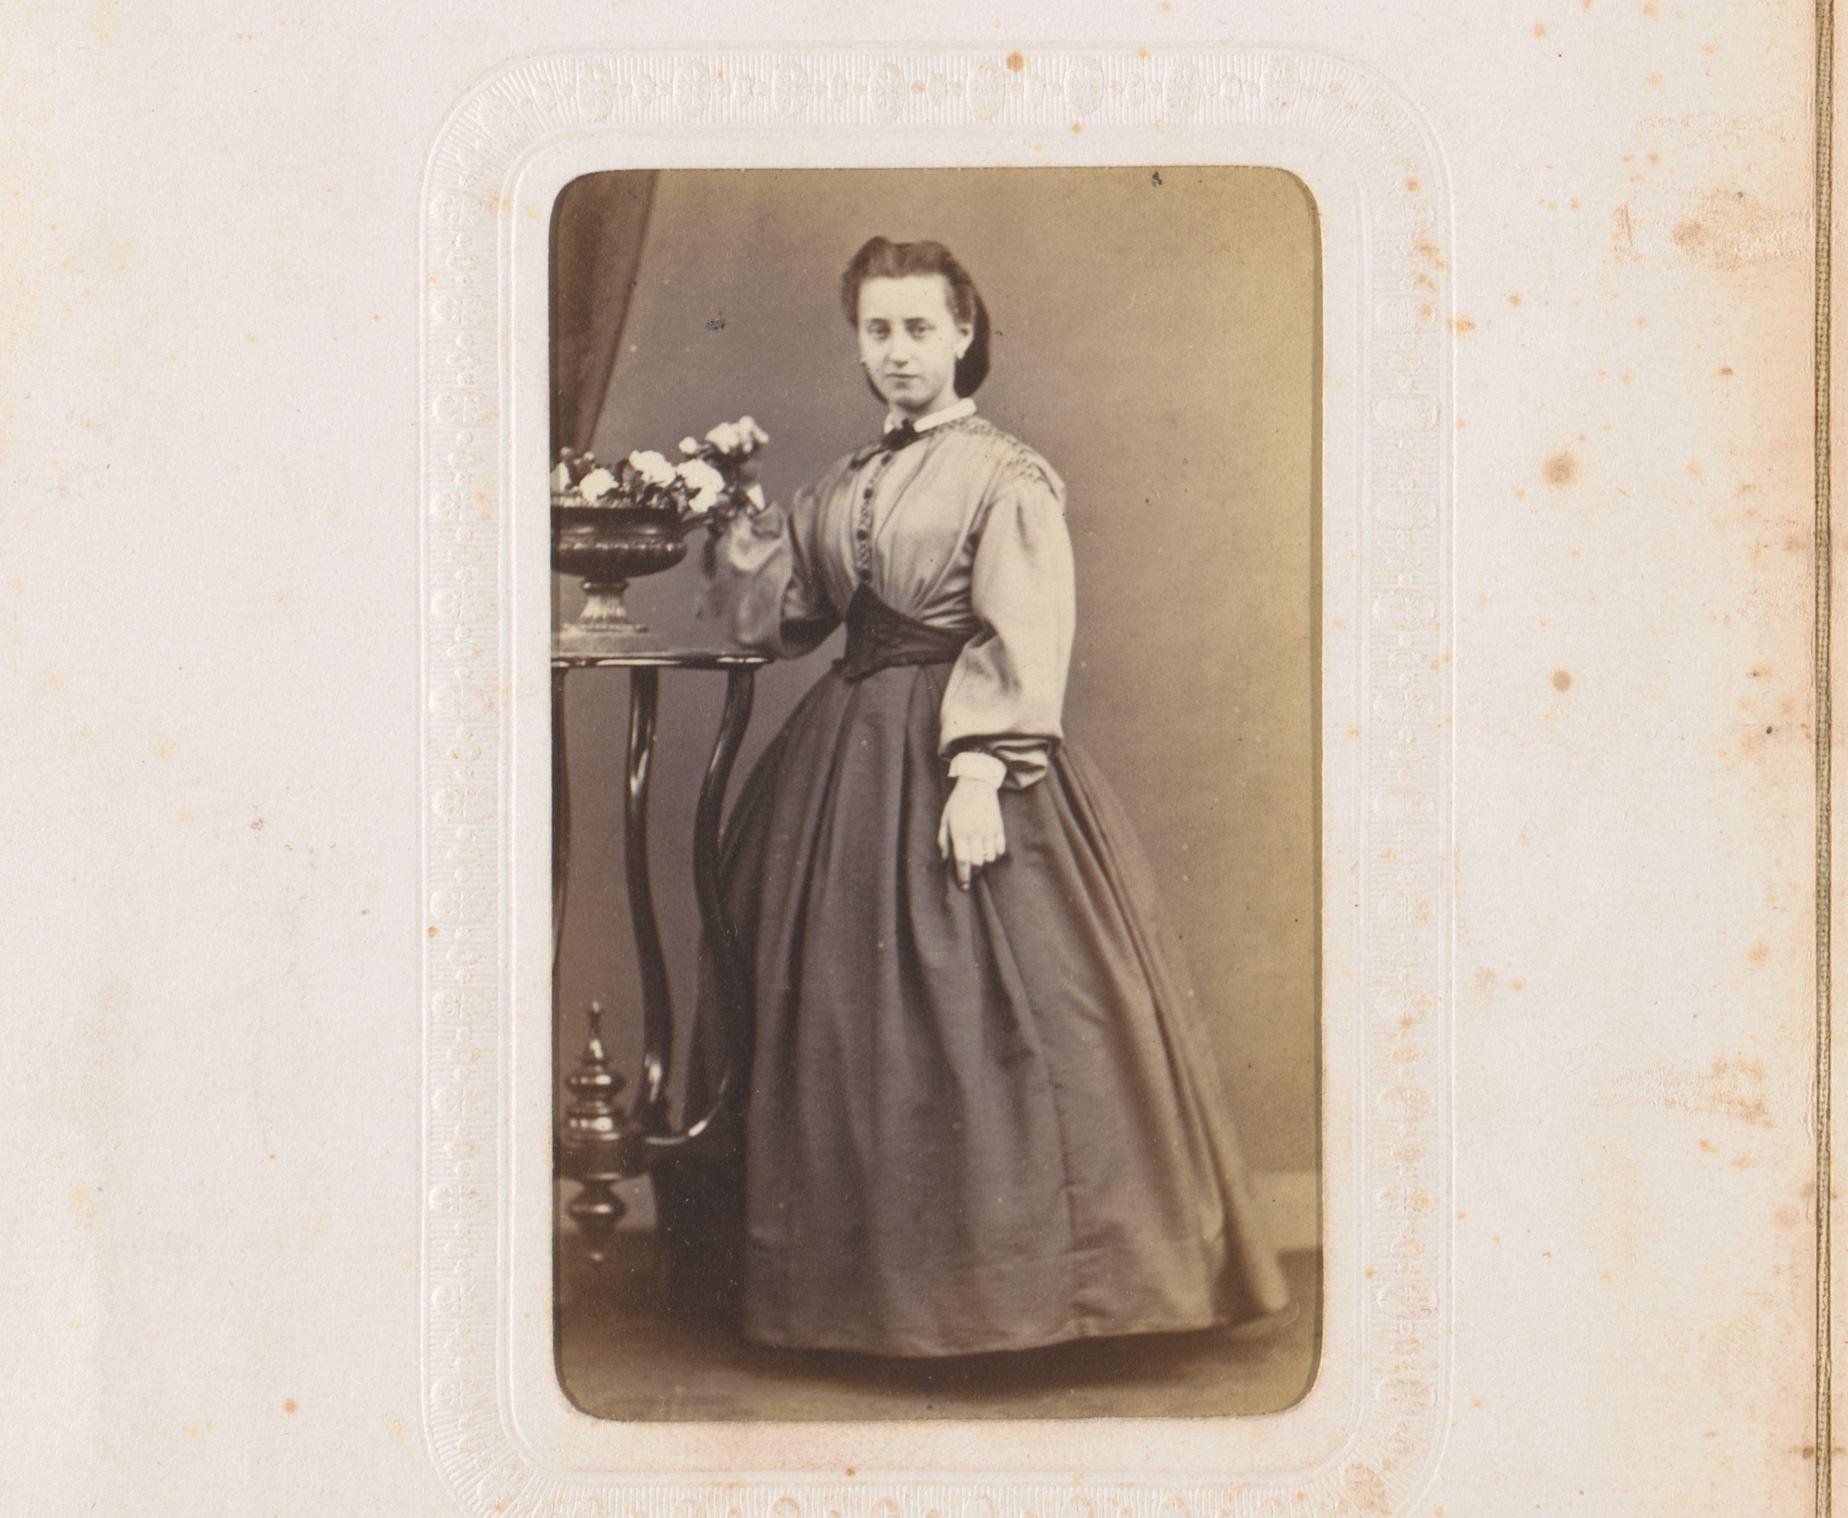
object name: photograph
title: Portret van een vrouw, staand bij een hoge tafel met vaas met bloemen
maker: Anonymous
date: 1860-1900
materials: cardboard, photographic support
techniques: albumen print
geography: netherlands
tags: flowers, historical persons - bb - woman, table, standing figure - aa - female human figure